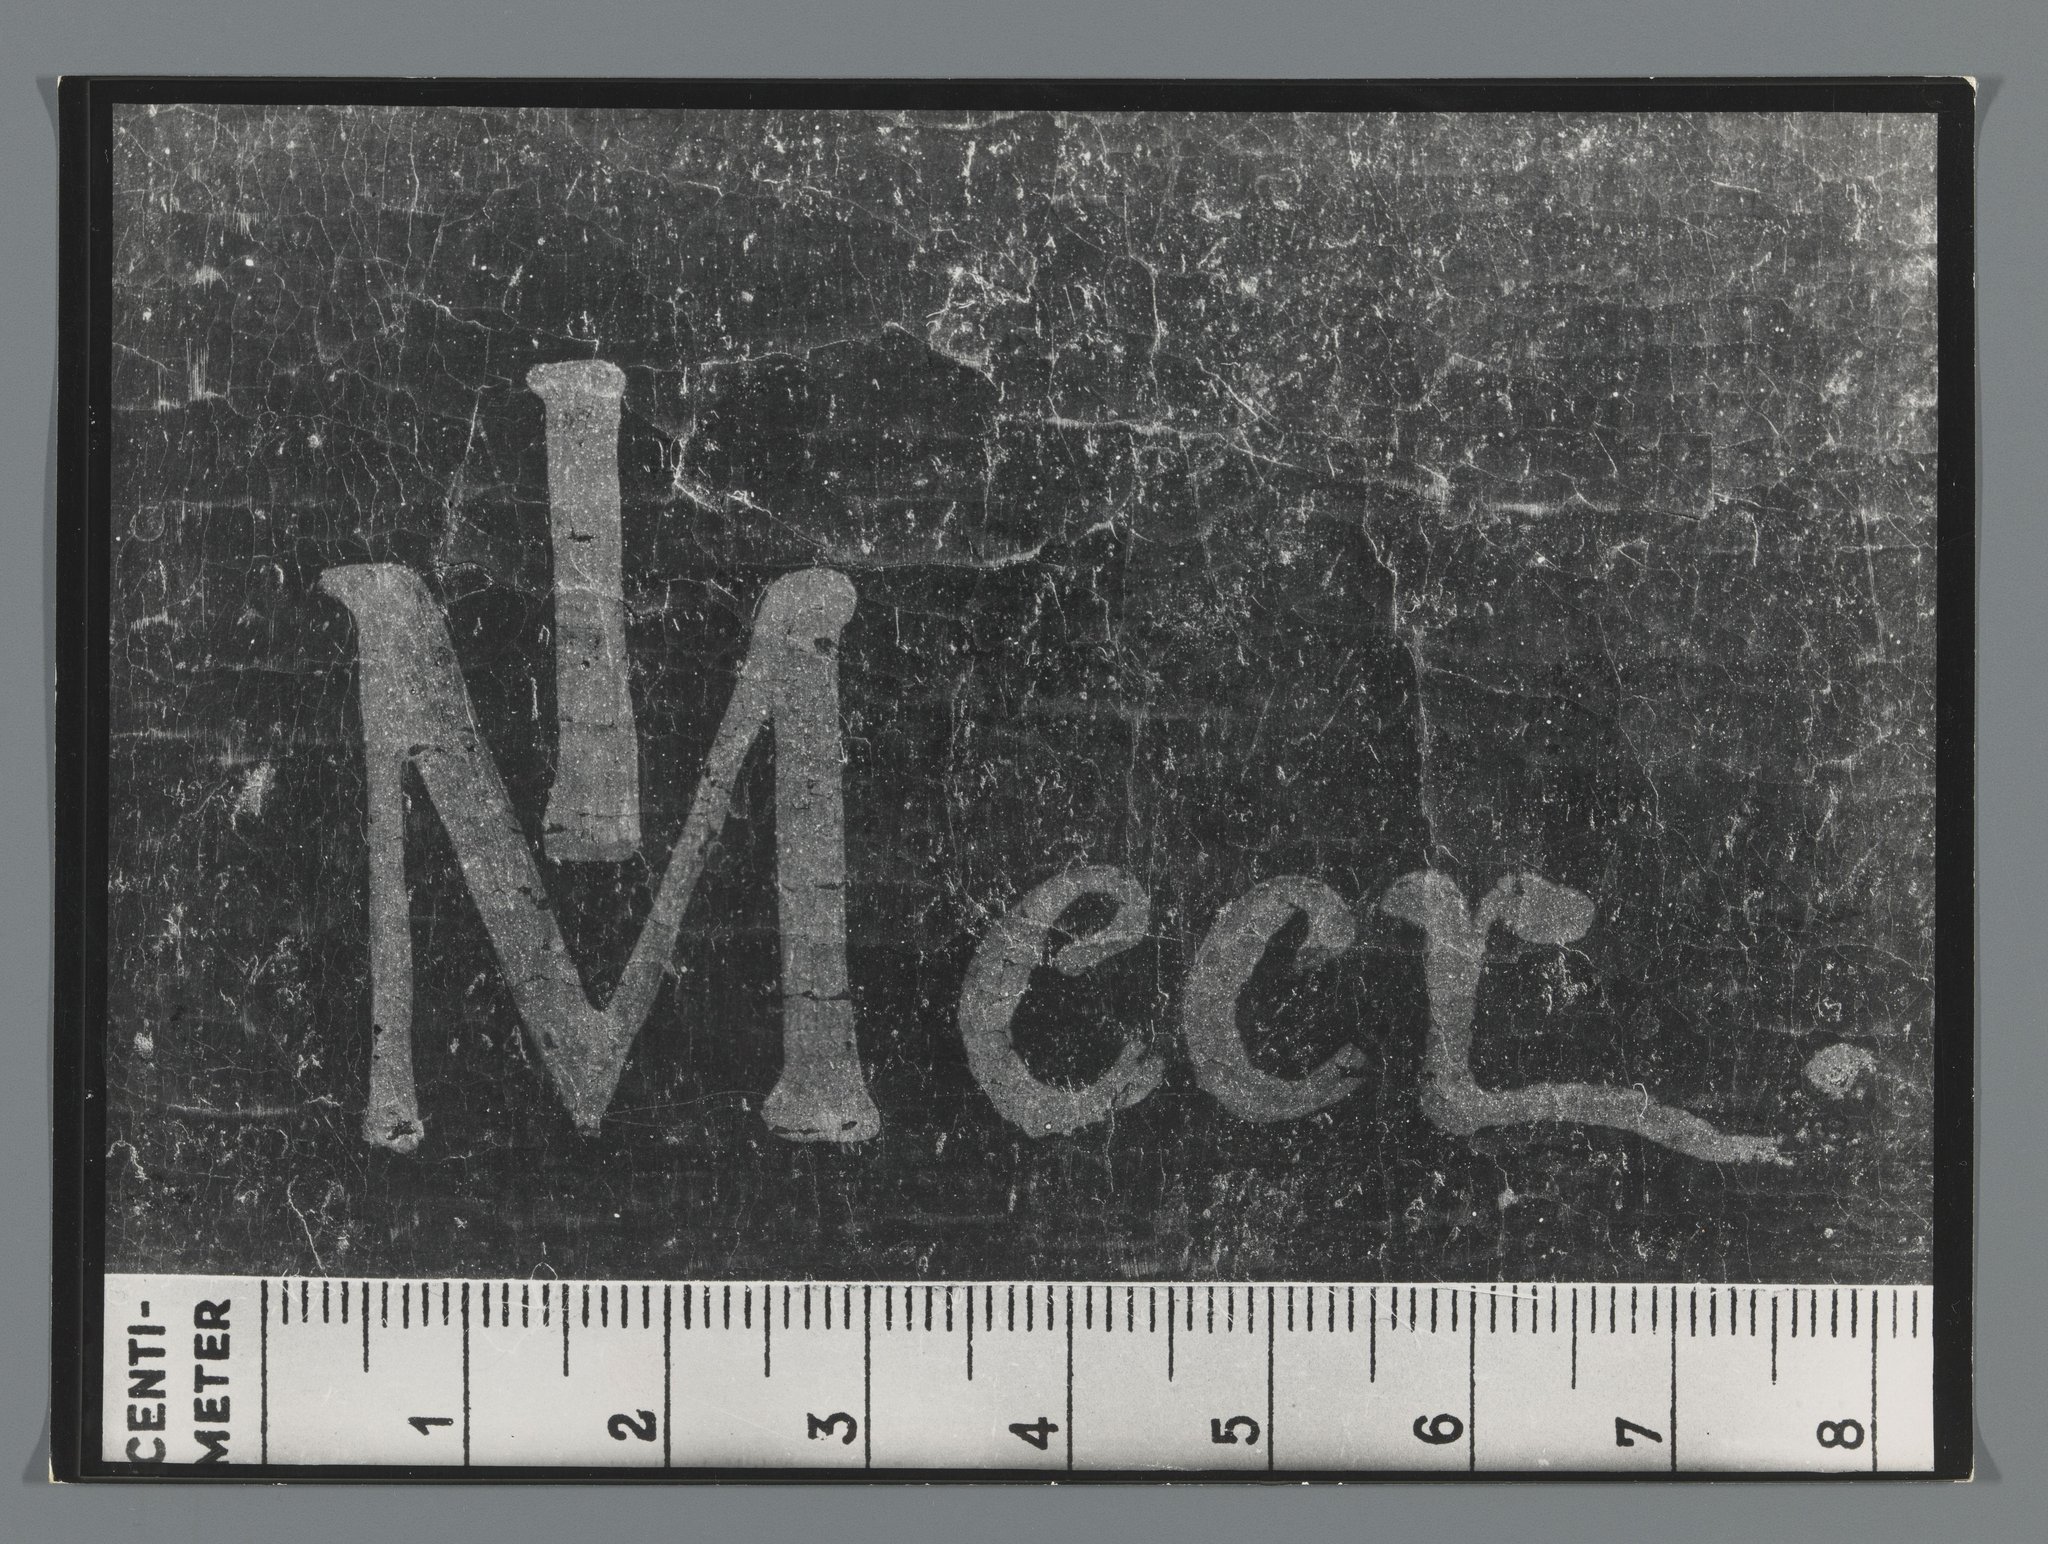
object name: photograph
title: Fotografische reproductie van een (detail) schilderij van Han van Meegeren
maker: nico zomer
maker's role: fotograaf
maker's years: 1910-1988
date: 1908-1948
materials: photographic support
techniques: gelatin silver print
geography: amsterdam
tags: picture, painting